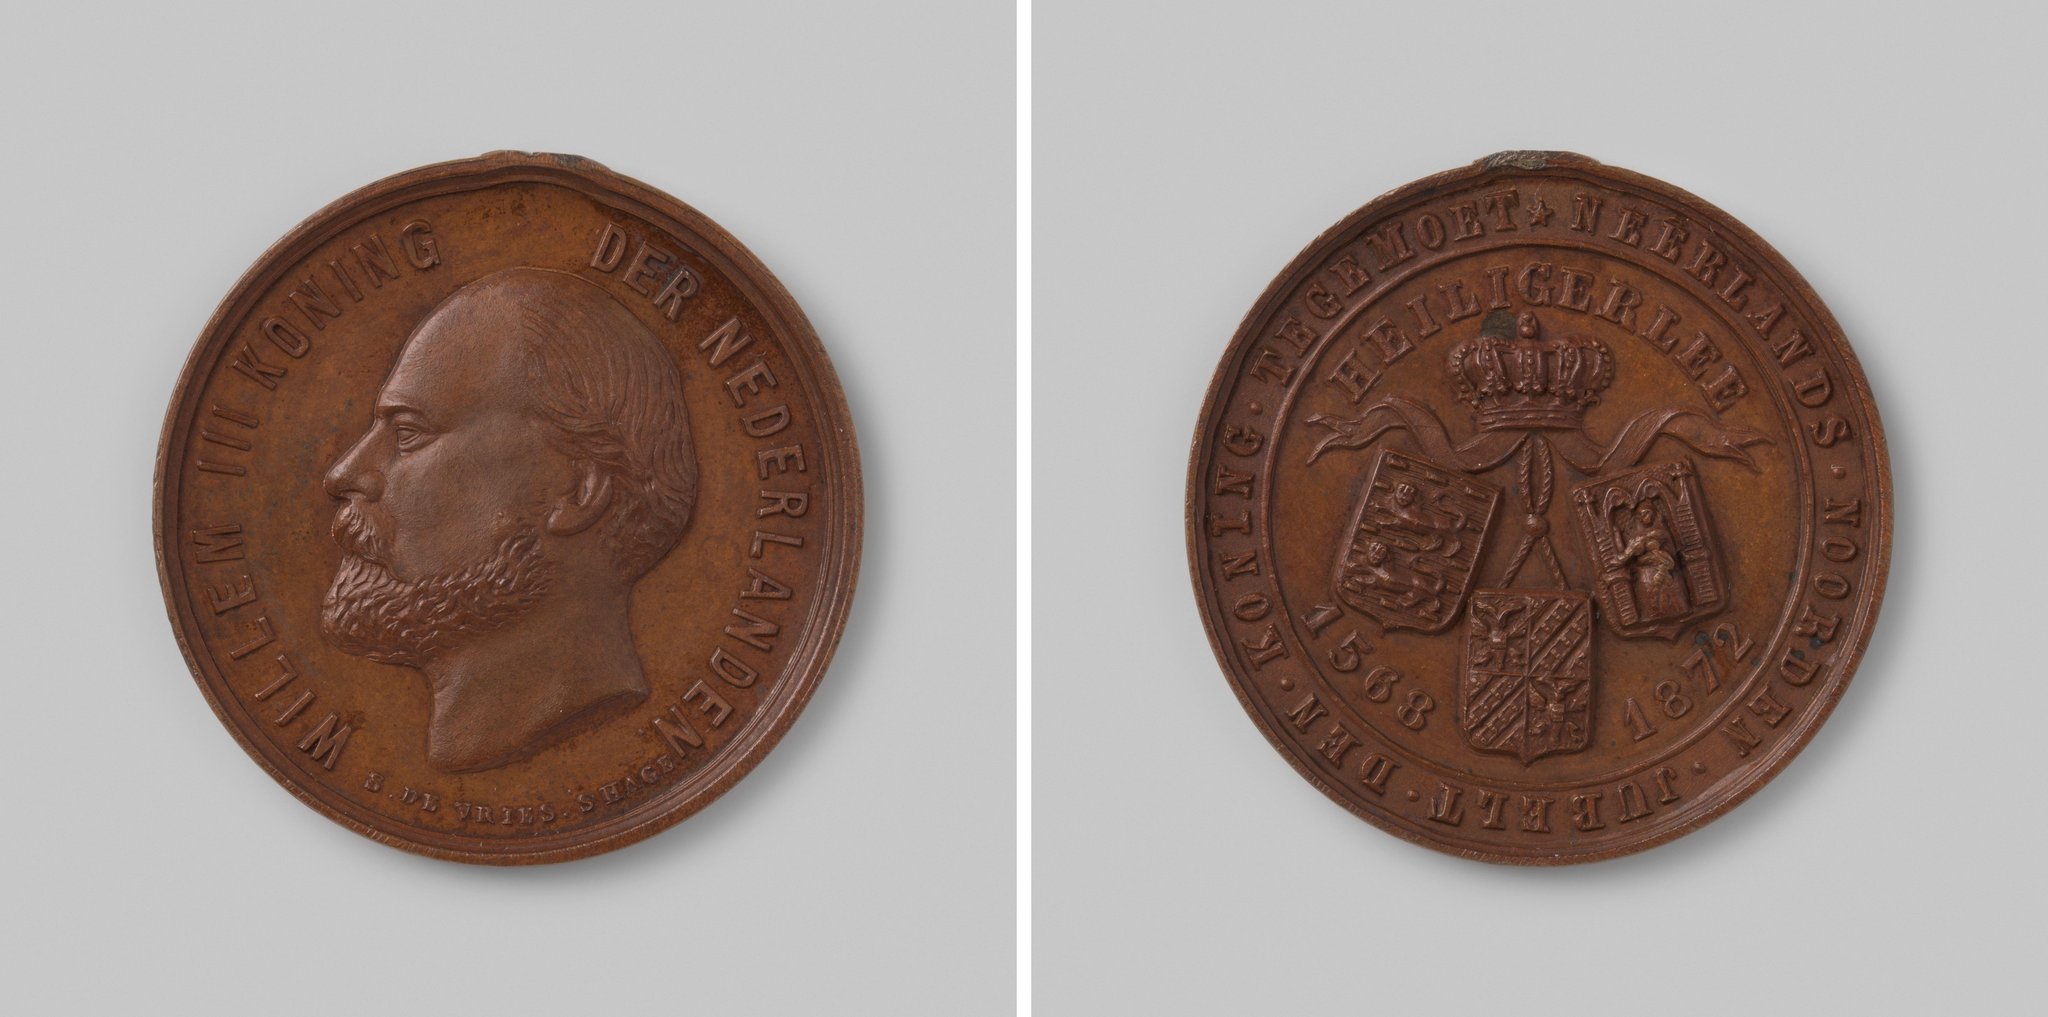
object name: history medal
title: Voorgenomen onthulling van het monument ter nagedachtenis aan Adolf, graaf van Nassau en de slag bij Heiligerlee, penning ter ere van Willem III, koning der Nederlanden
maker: salomon de vries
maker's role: graveur, medailleur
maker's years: 1830-1899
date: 1872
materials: bronze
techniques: striking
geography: the hague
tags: willem iii (koning der nederlanden)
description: Bronzen penning. Voorzijde: borststuk man binnen omschrift. Keerzijde: drie wapenschilden met lint verbonden met kroon binnen tweeregelig omschrift